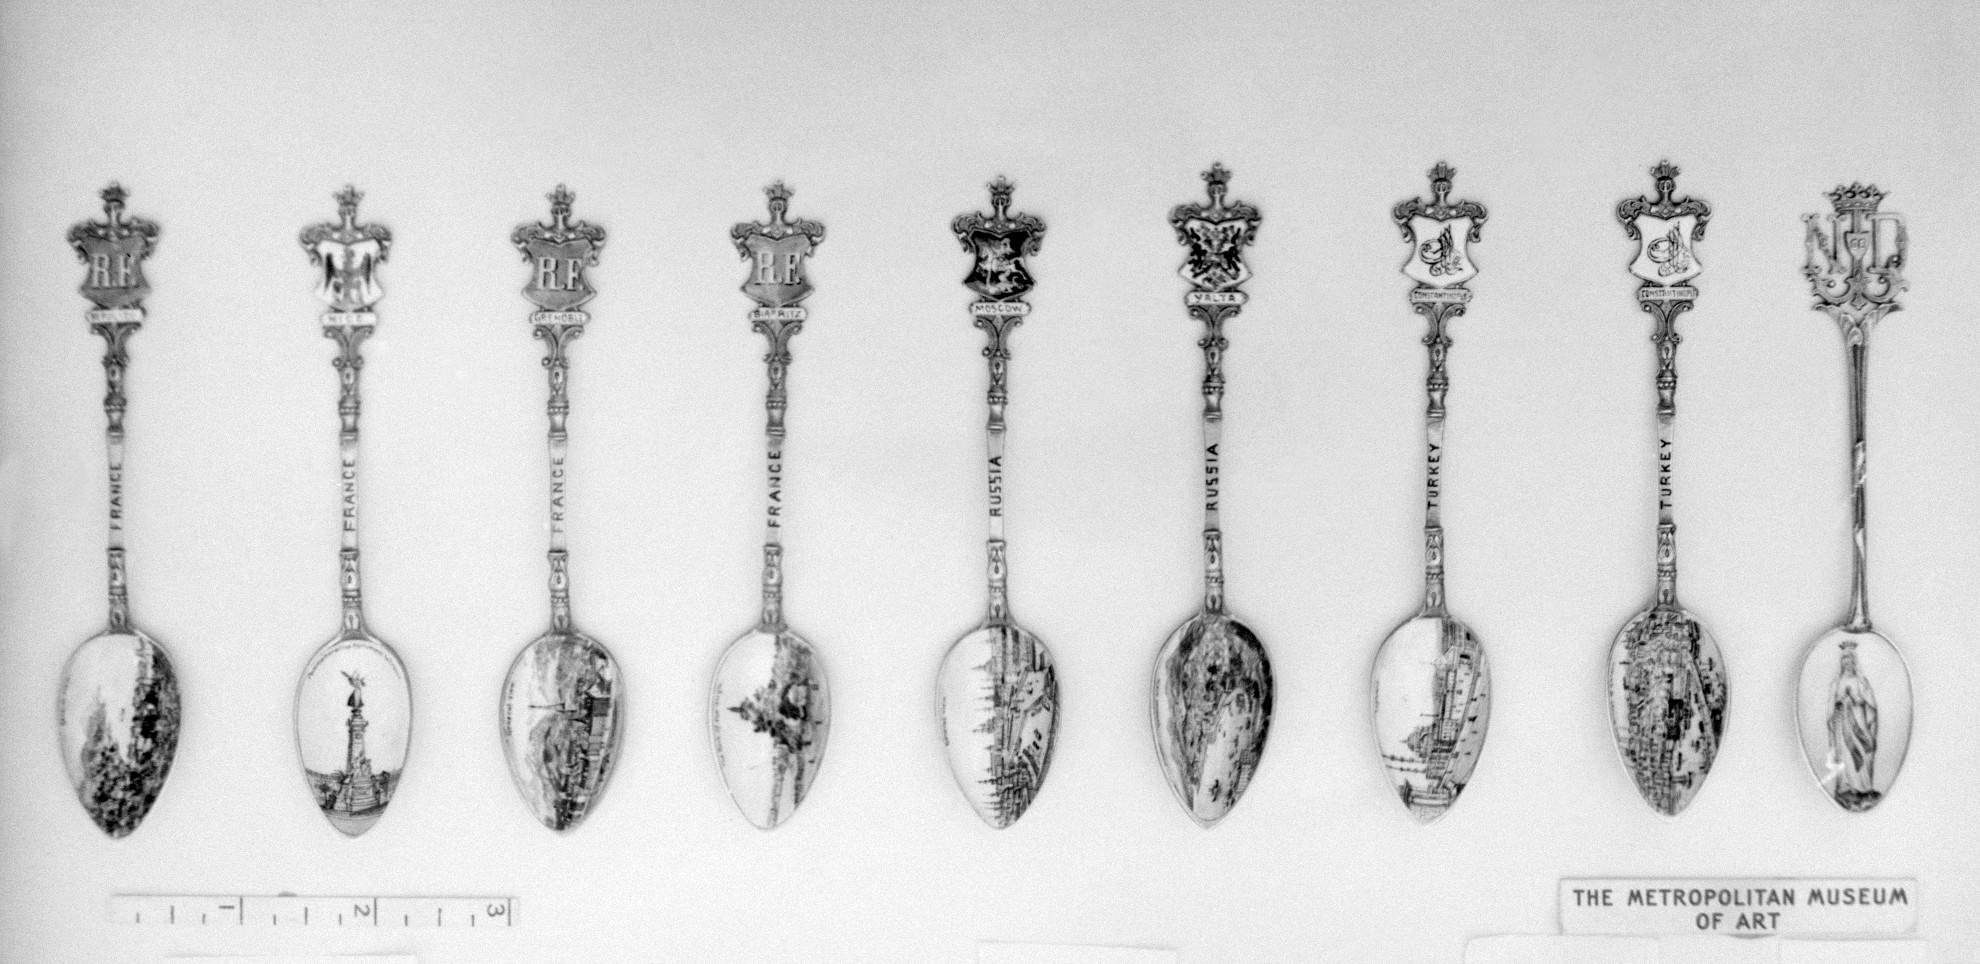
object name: souvenir spoon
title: Souvenir spoon with view of a city and a mosque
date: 1867-1900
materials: enamel, silver gilt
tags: coat of arms